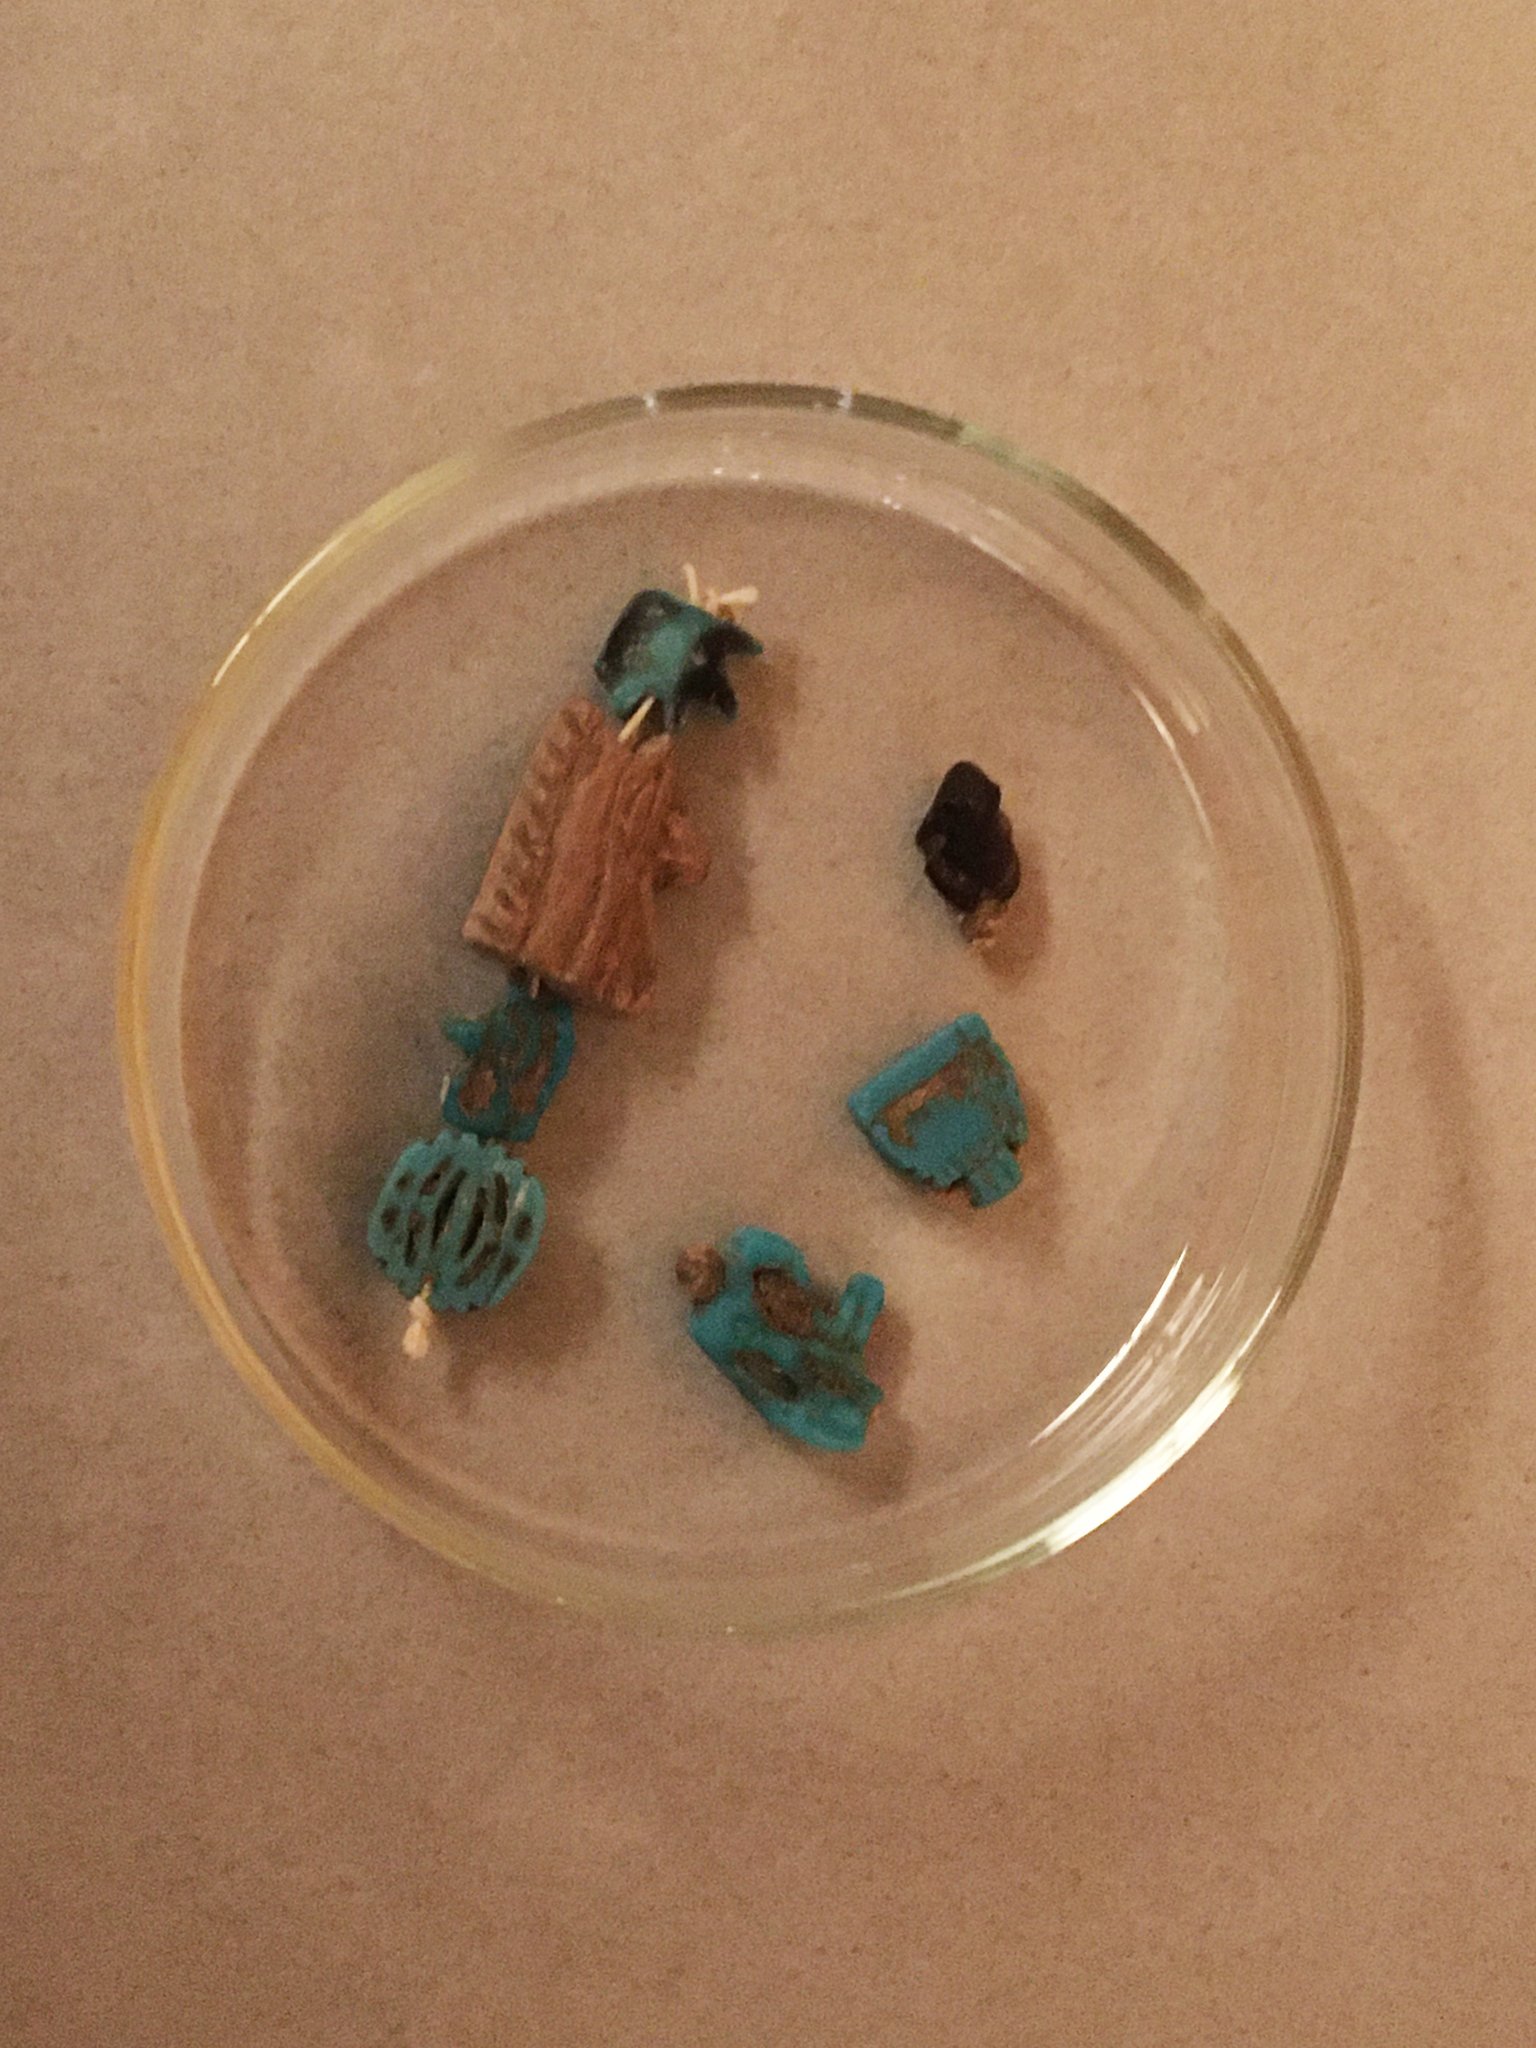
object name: amulet, wedjat eye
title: String of amulets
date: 712-525 BCE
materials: faience, mineral, wood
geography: egypt